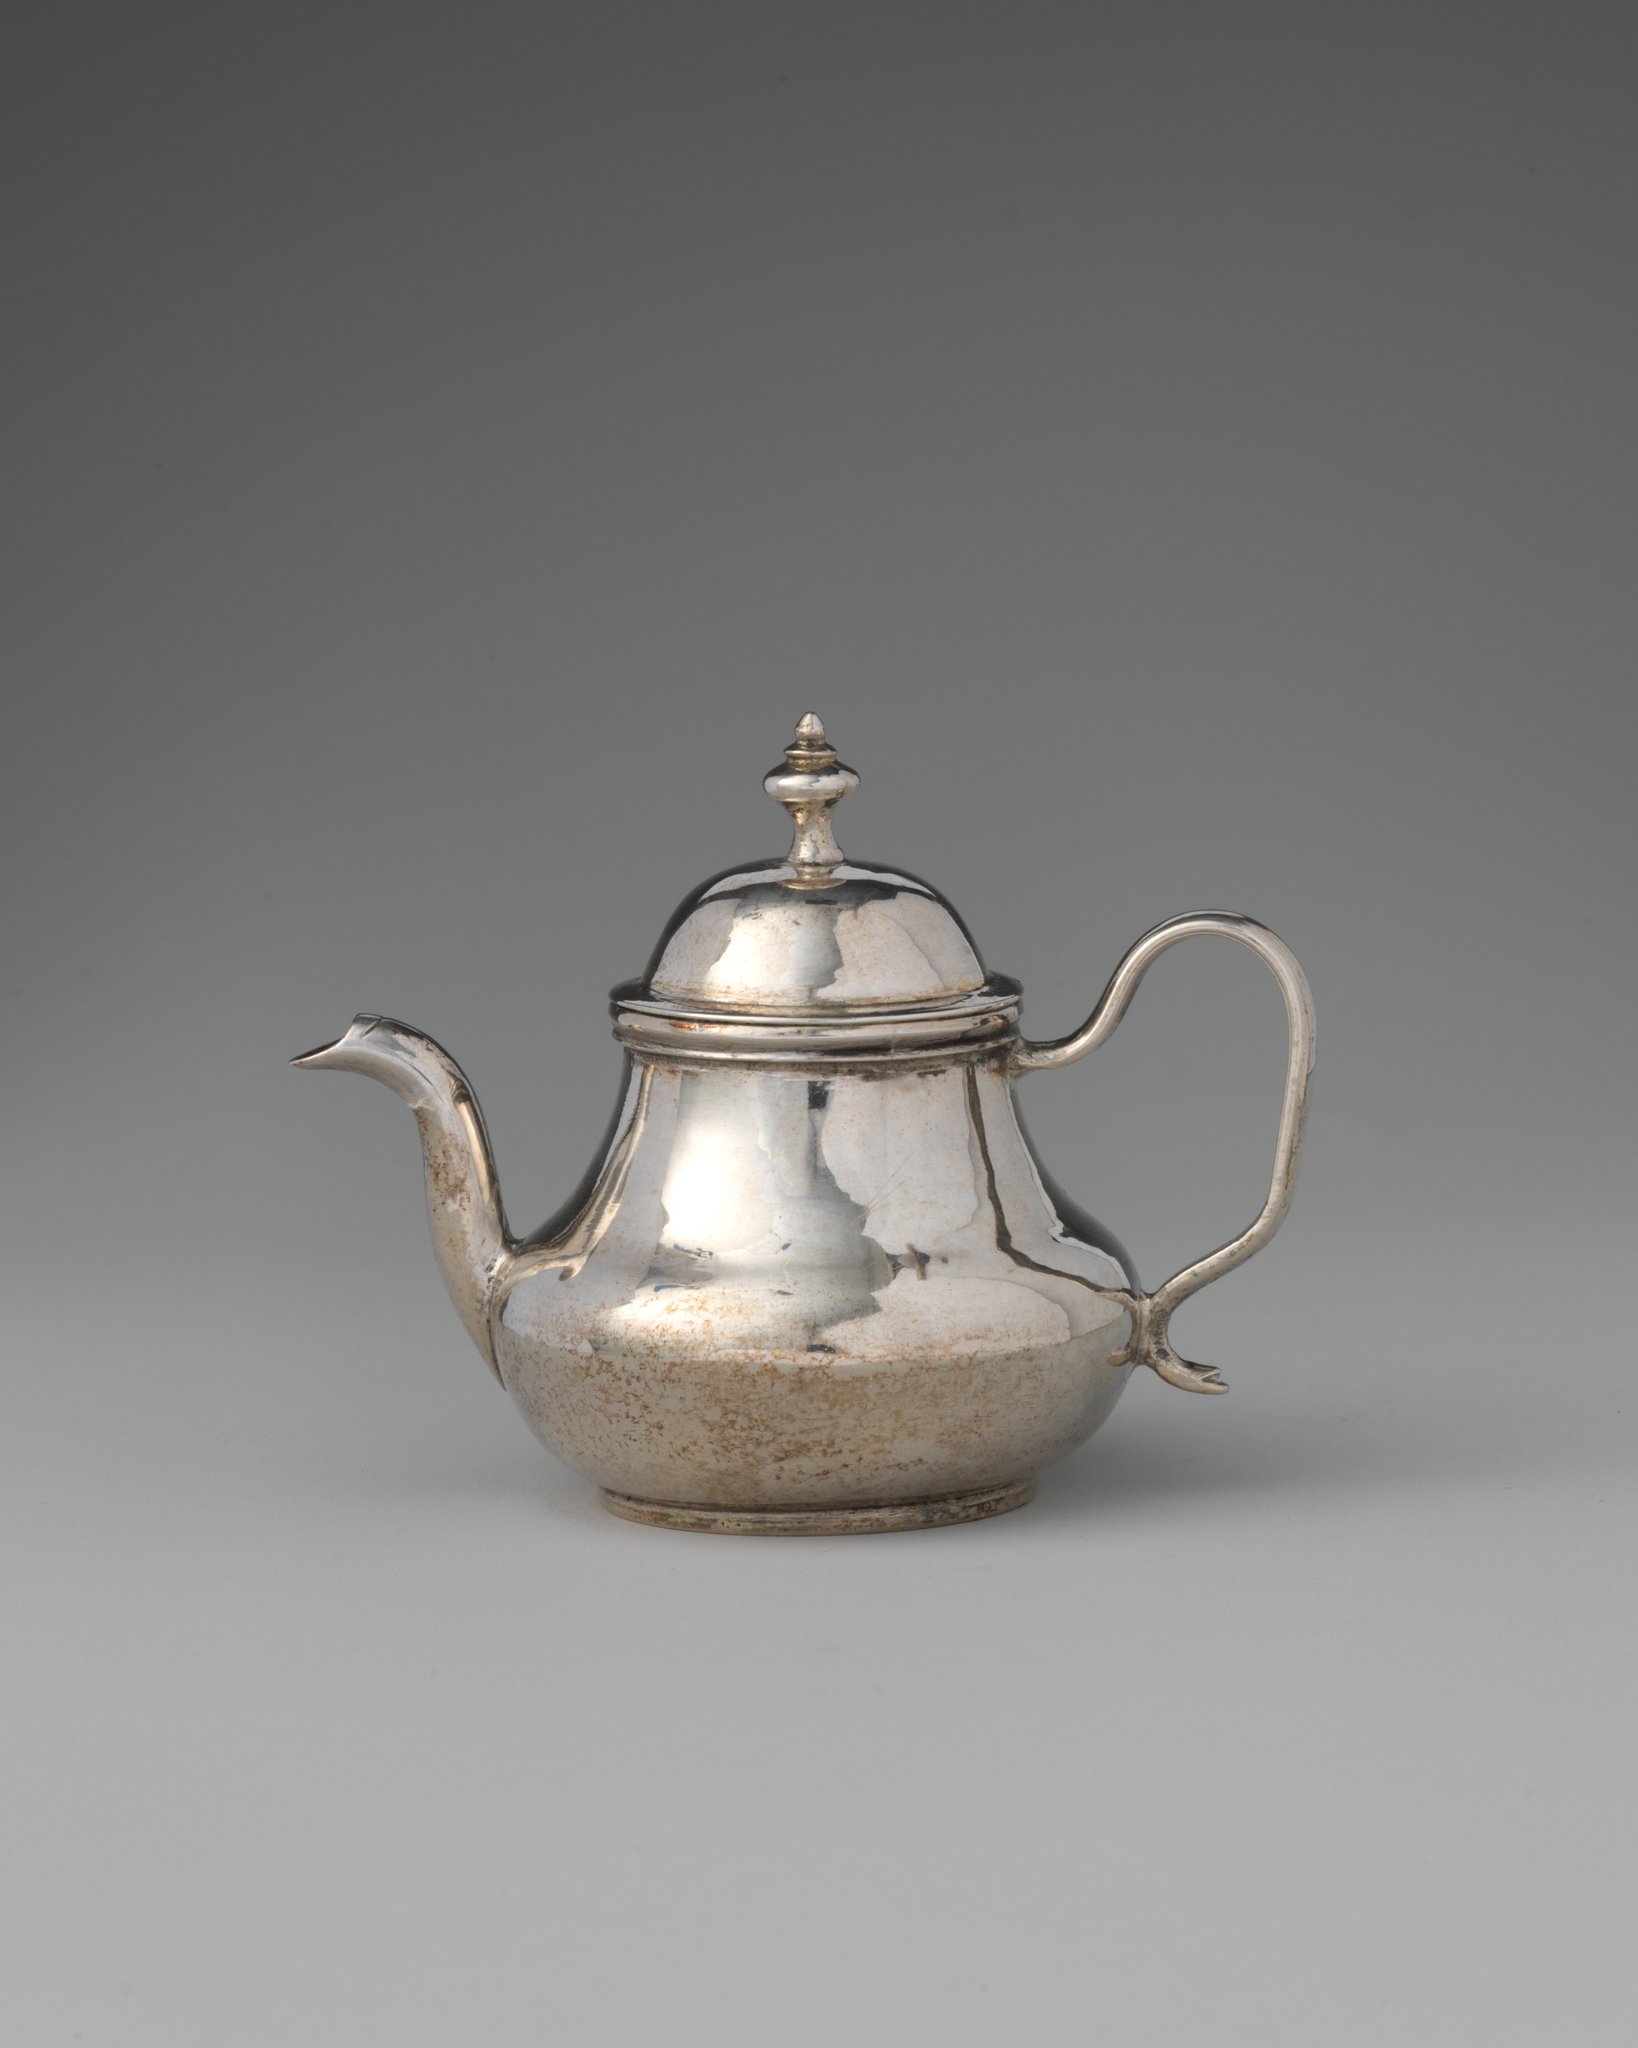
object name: teapot with cover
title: Miniature teapot with cover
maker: johannes van geffen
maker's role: maker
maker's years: 1769-1788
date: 1780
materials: silver